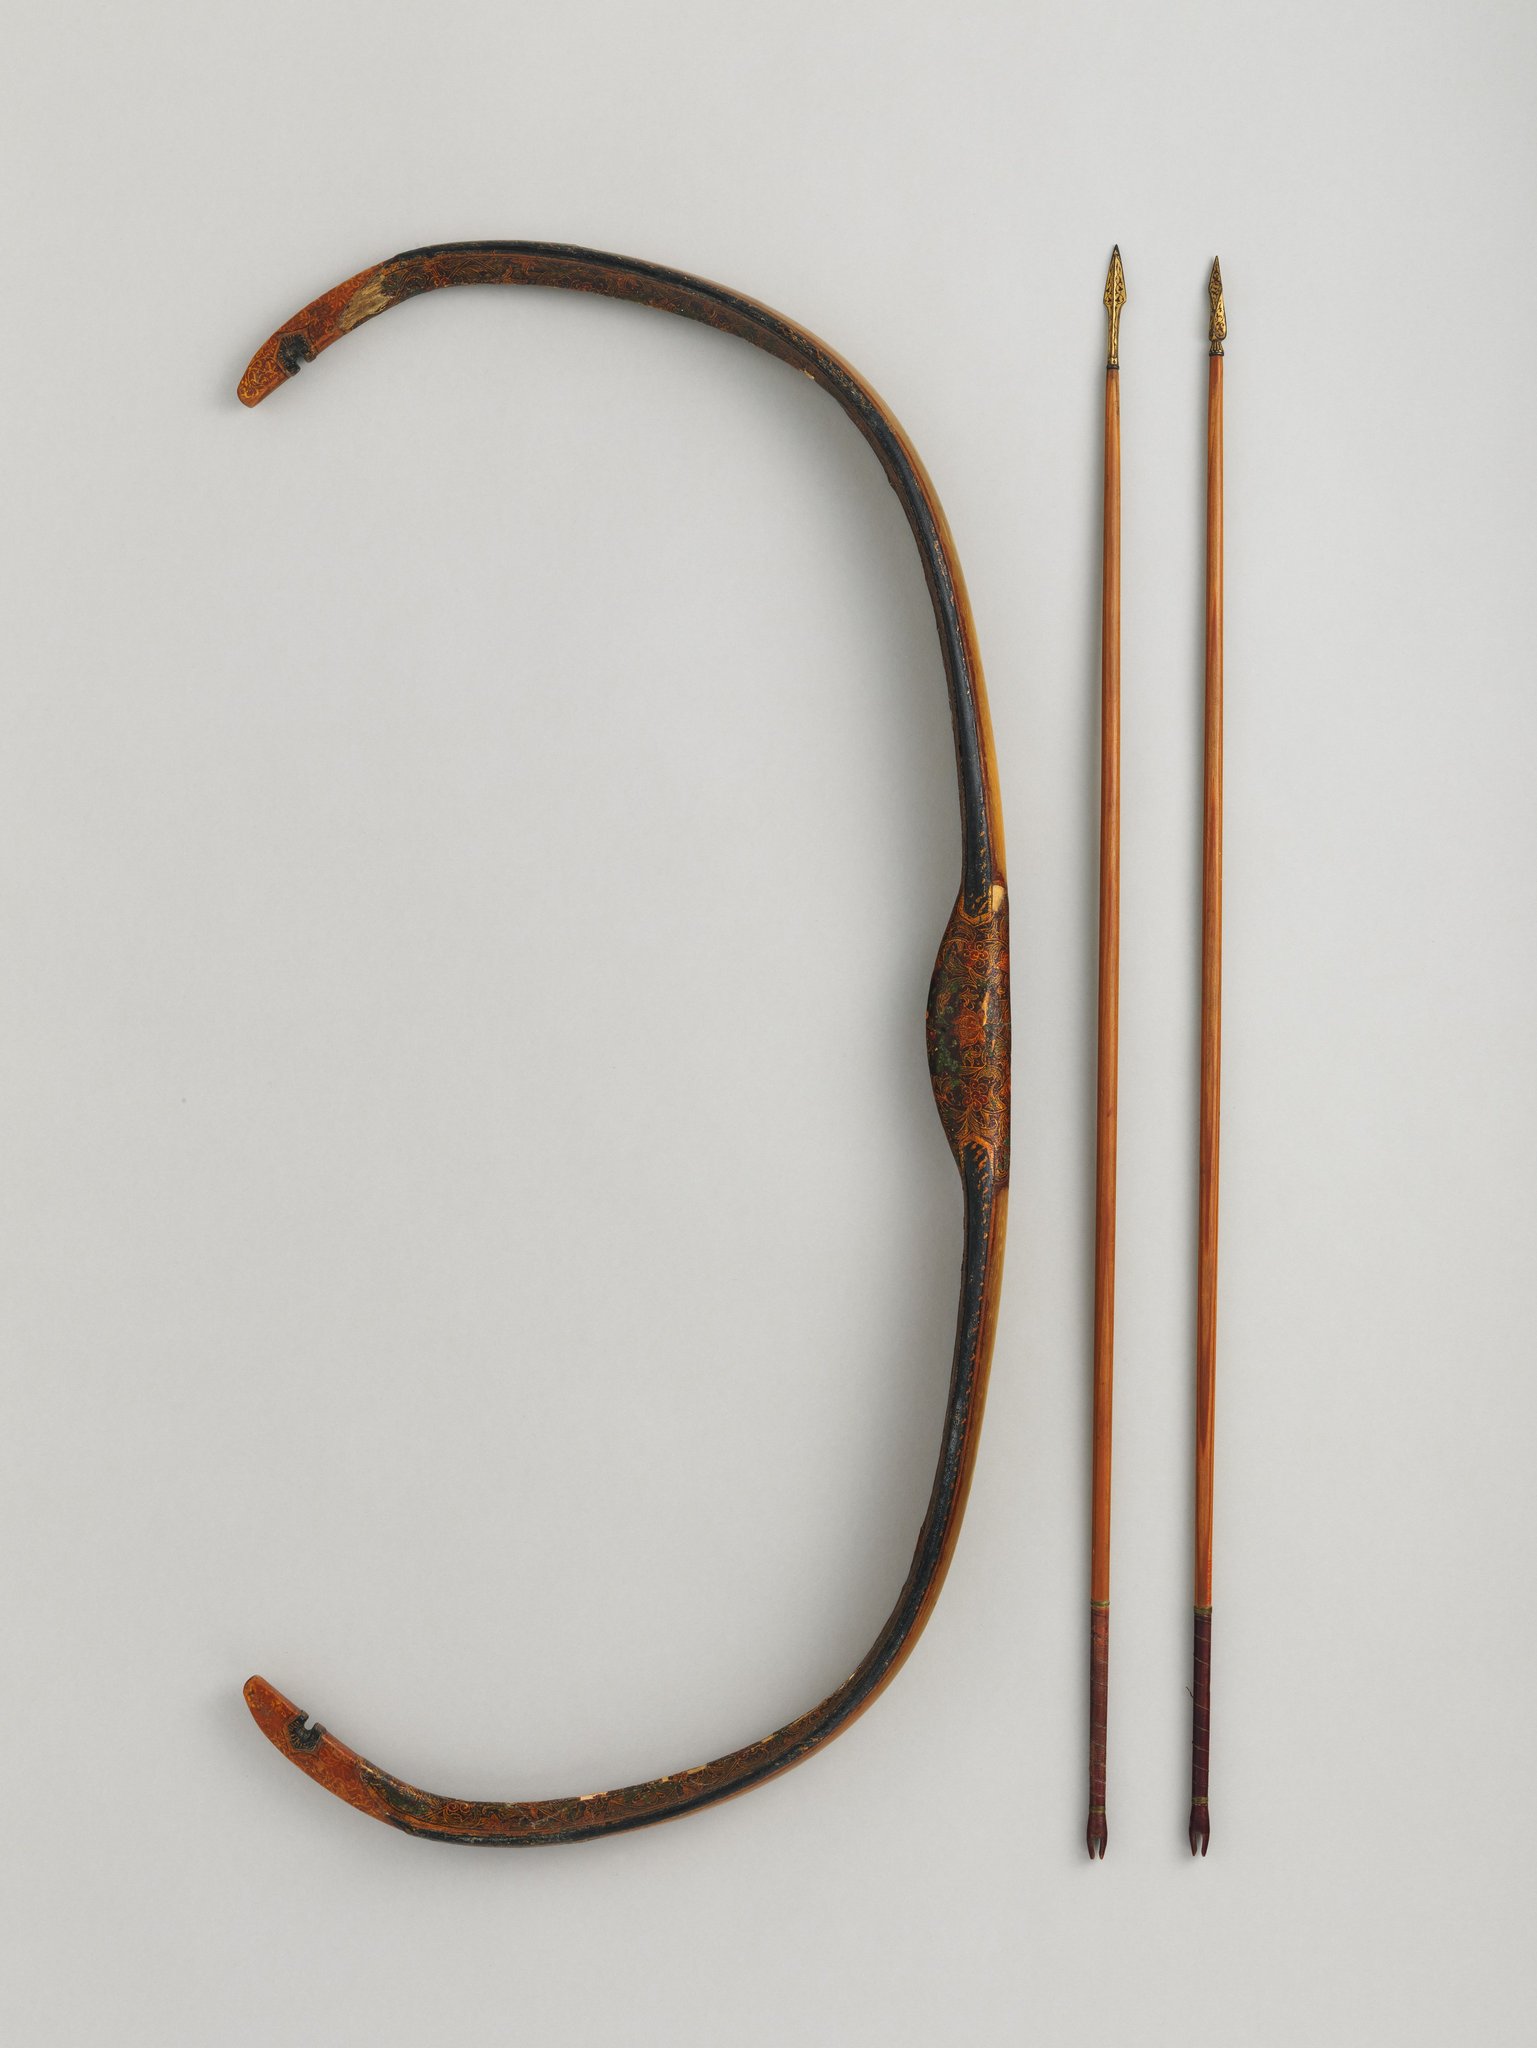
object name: composite bow with forty arrow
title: Composite Bow with Forty Arrows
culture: turkish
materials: feather, gold, horn, iron, ivory, lacquer, paper, pigment, silk, silver, wood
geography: turkey